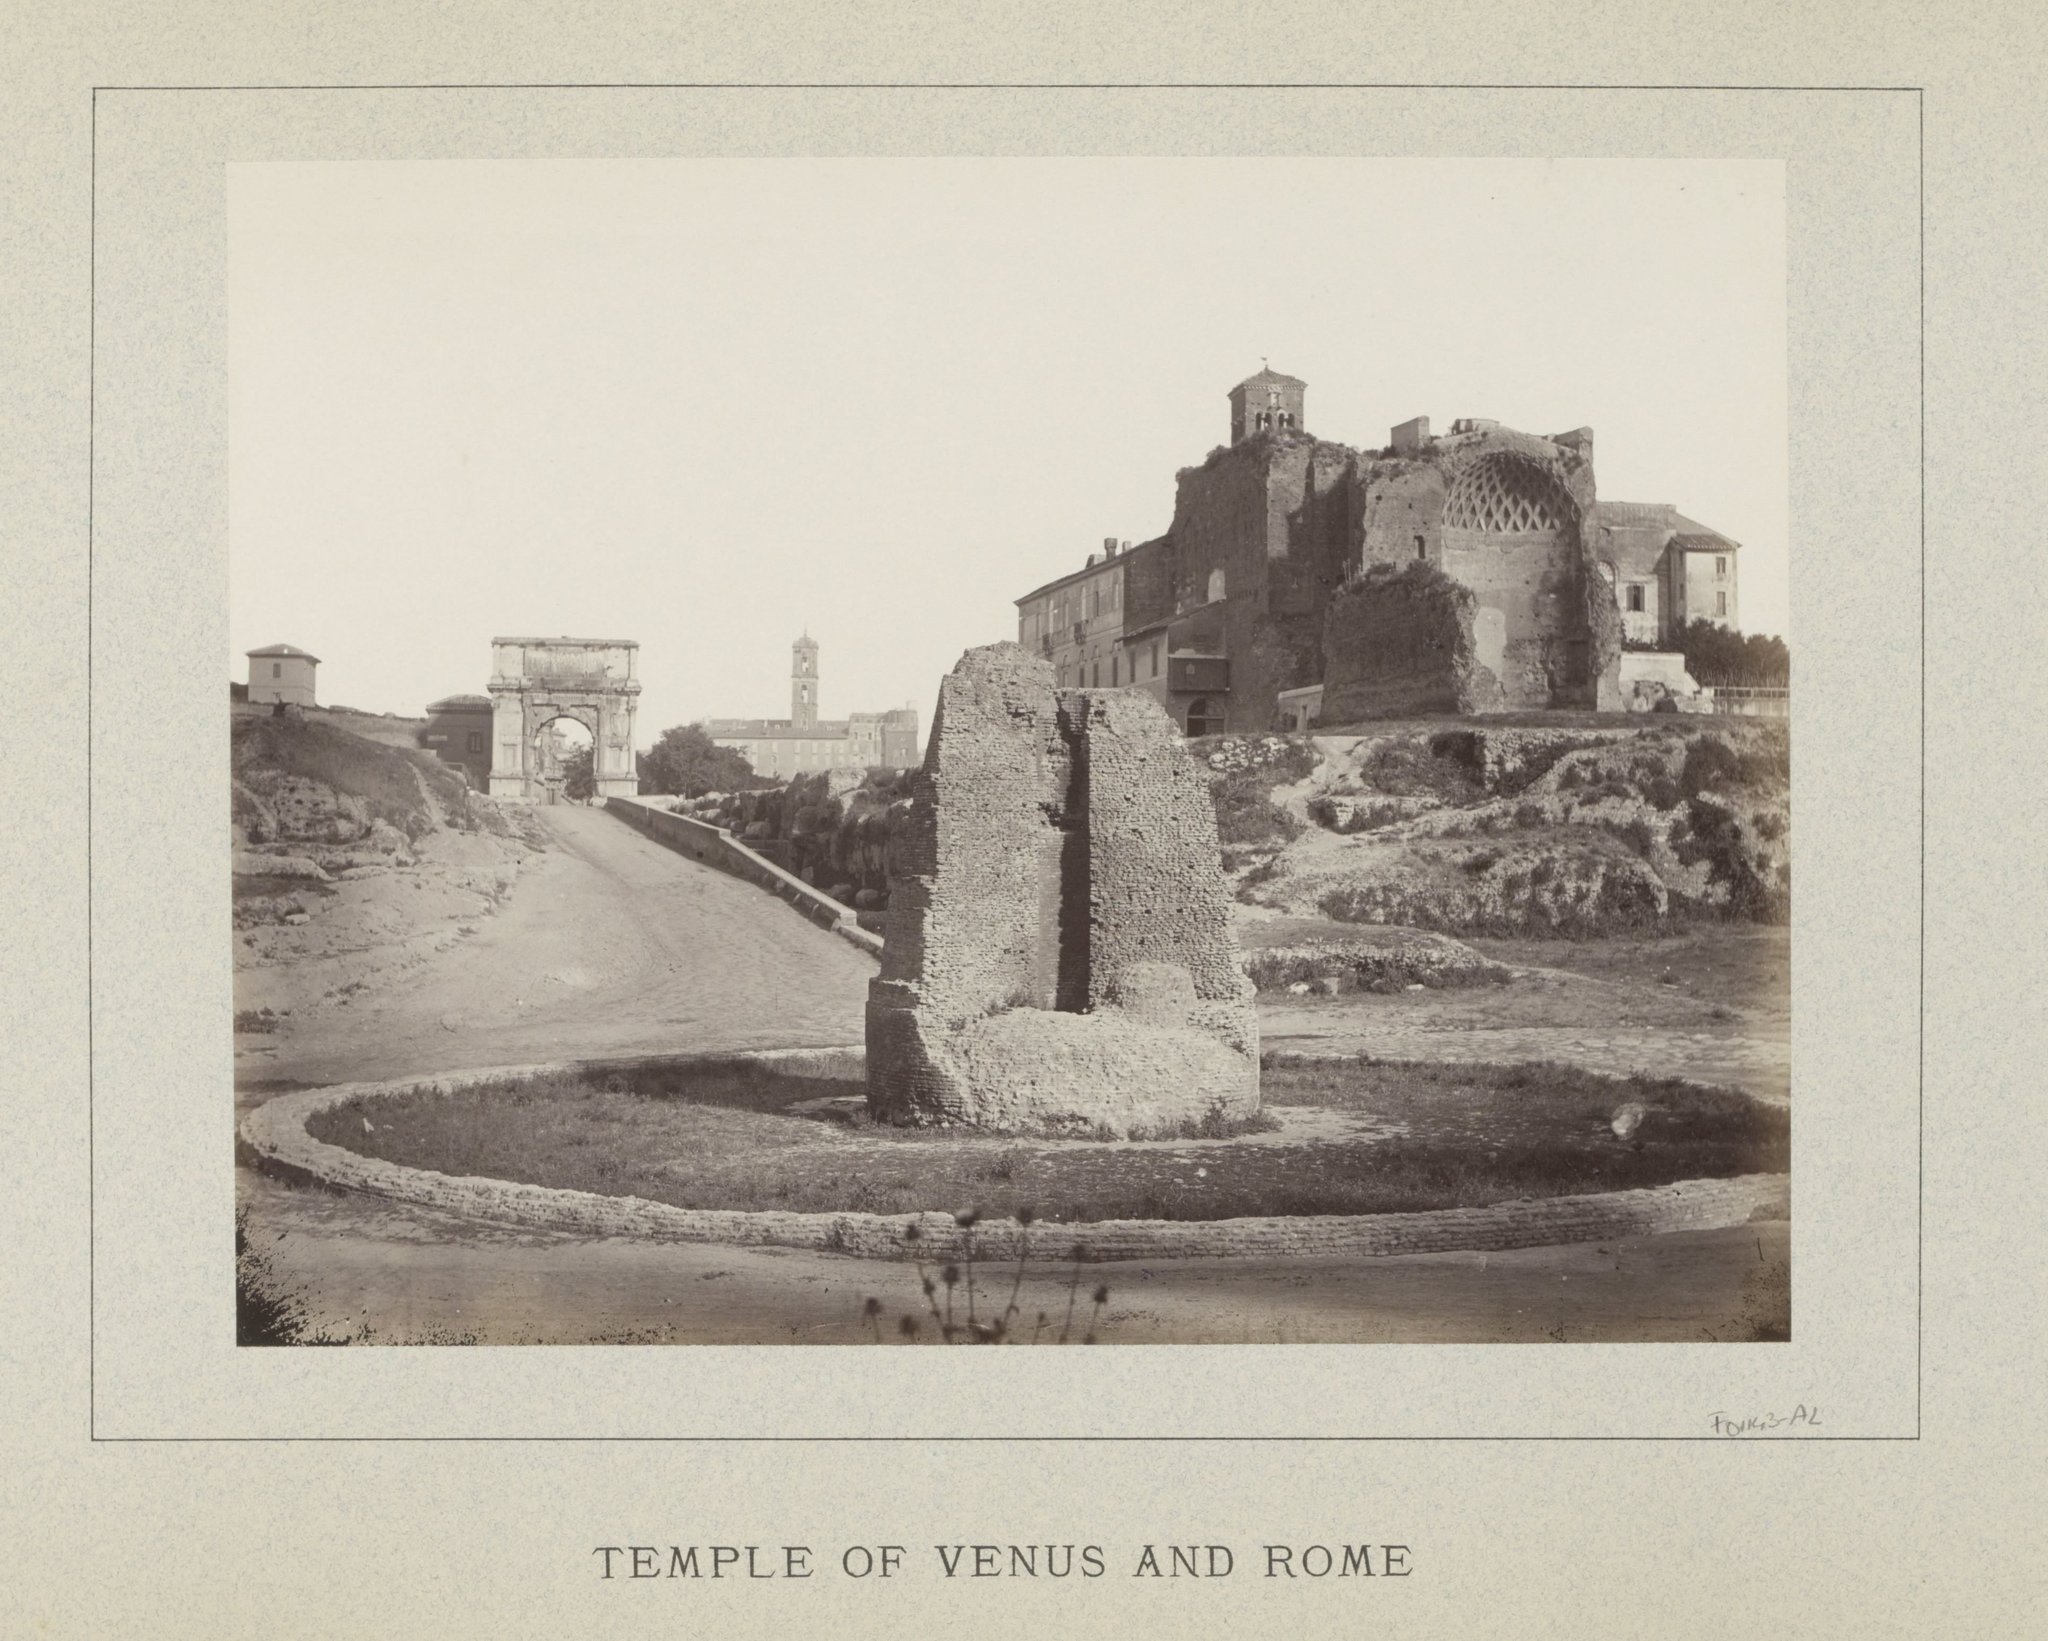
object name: photograph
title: Temple of Venus and Rome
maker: Anonymous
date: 1860-1900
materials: photographic support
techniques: albumen print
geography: rome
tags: parts of church interior: apse, temple, shrine ~ roman religion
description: Onderdeel van Fotoalbum met opnames van bezienswaardigheden en kunstwerken in Rome.